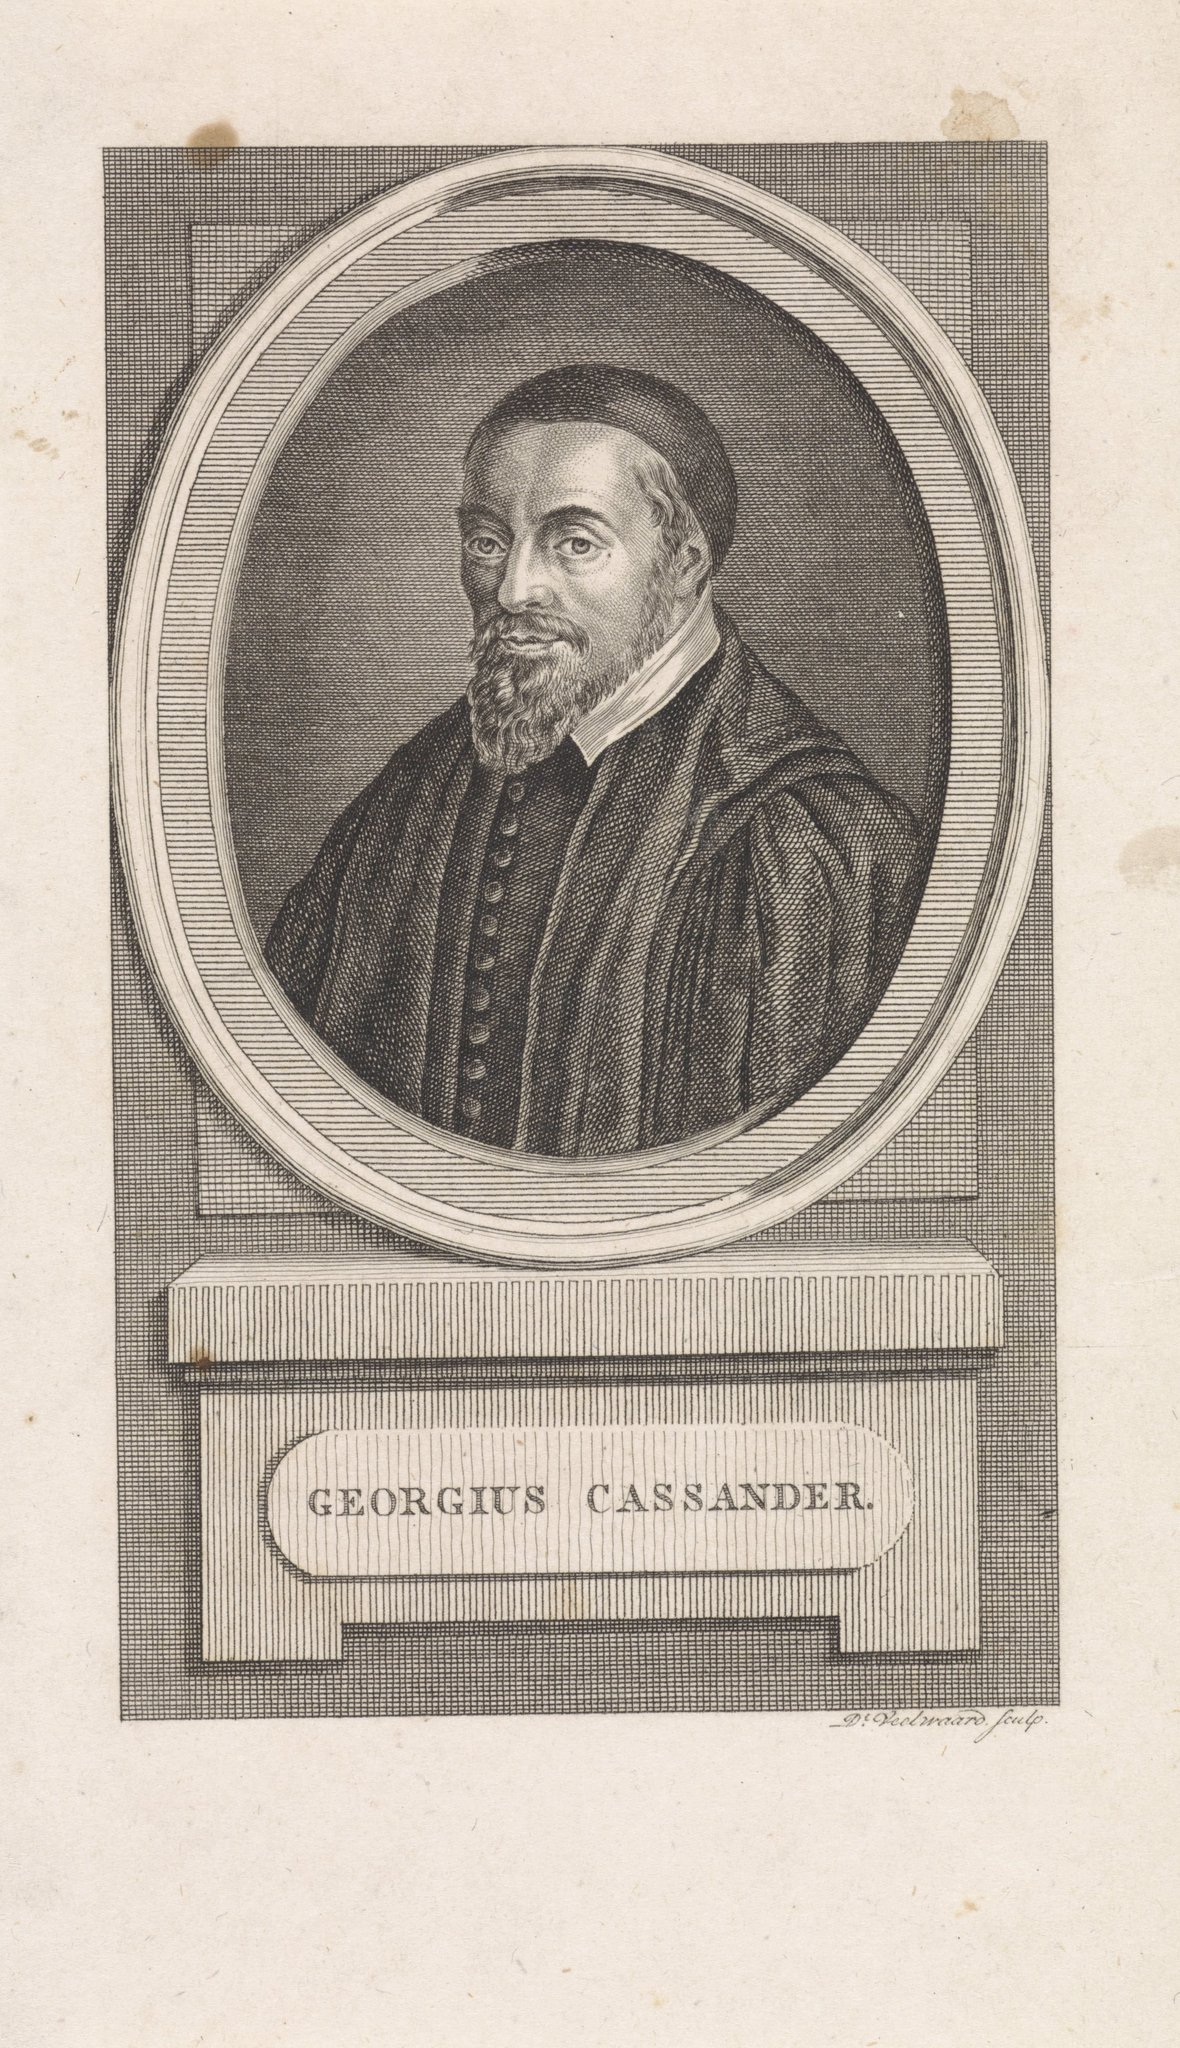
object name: print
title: Portret van de humanist Georgius Cassander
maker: daniël veelwaard (i)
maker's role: print maker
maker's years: 1766-1851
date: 1776-1851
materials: paper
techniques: engraving, etching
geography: amsterdam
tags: theoloog, humanist, joris cassander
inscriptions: collector's mark: Lugt 2228